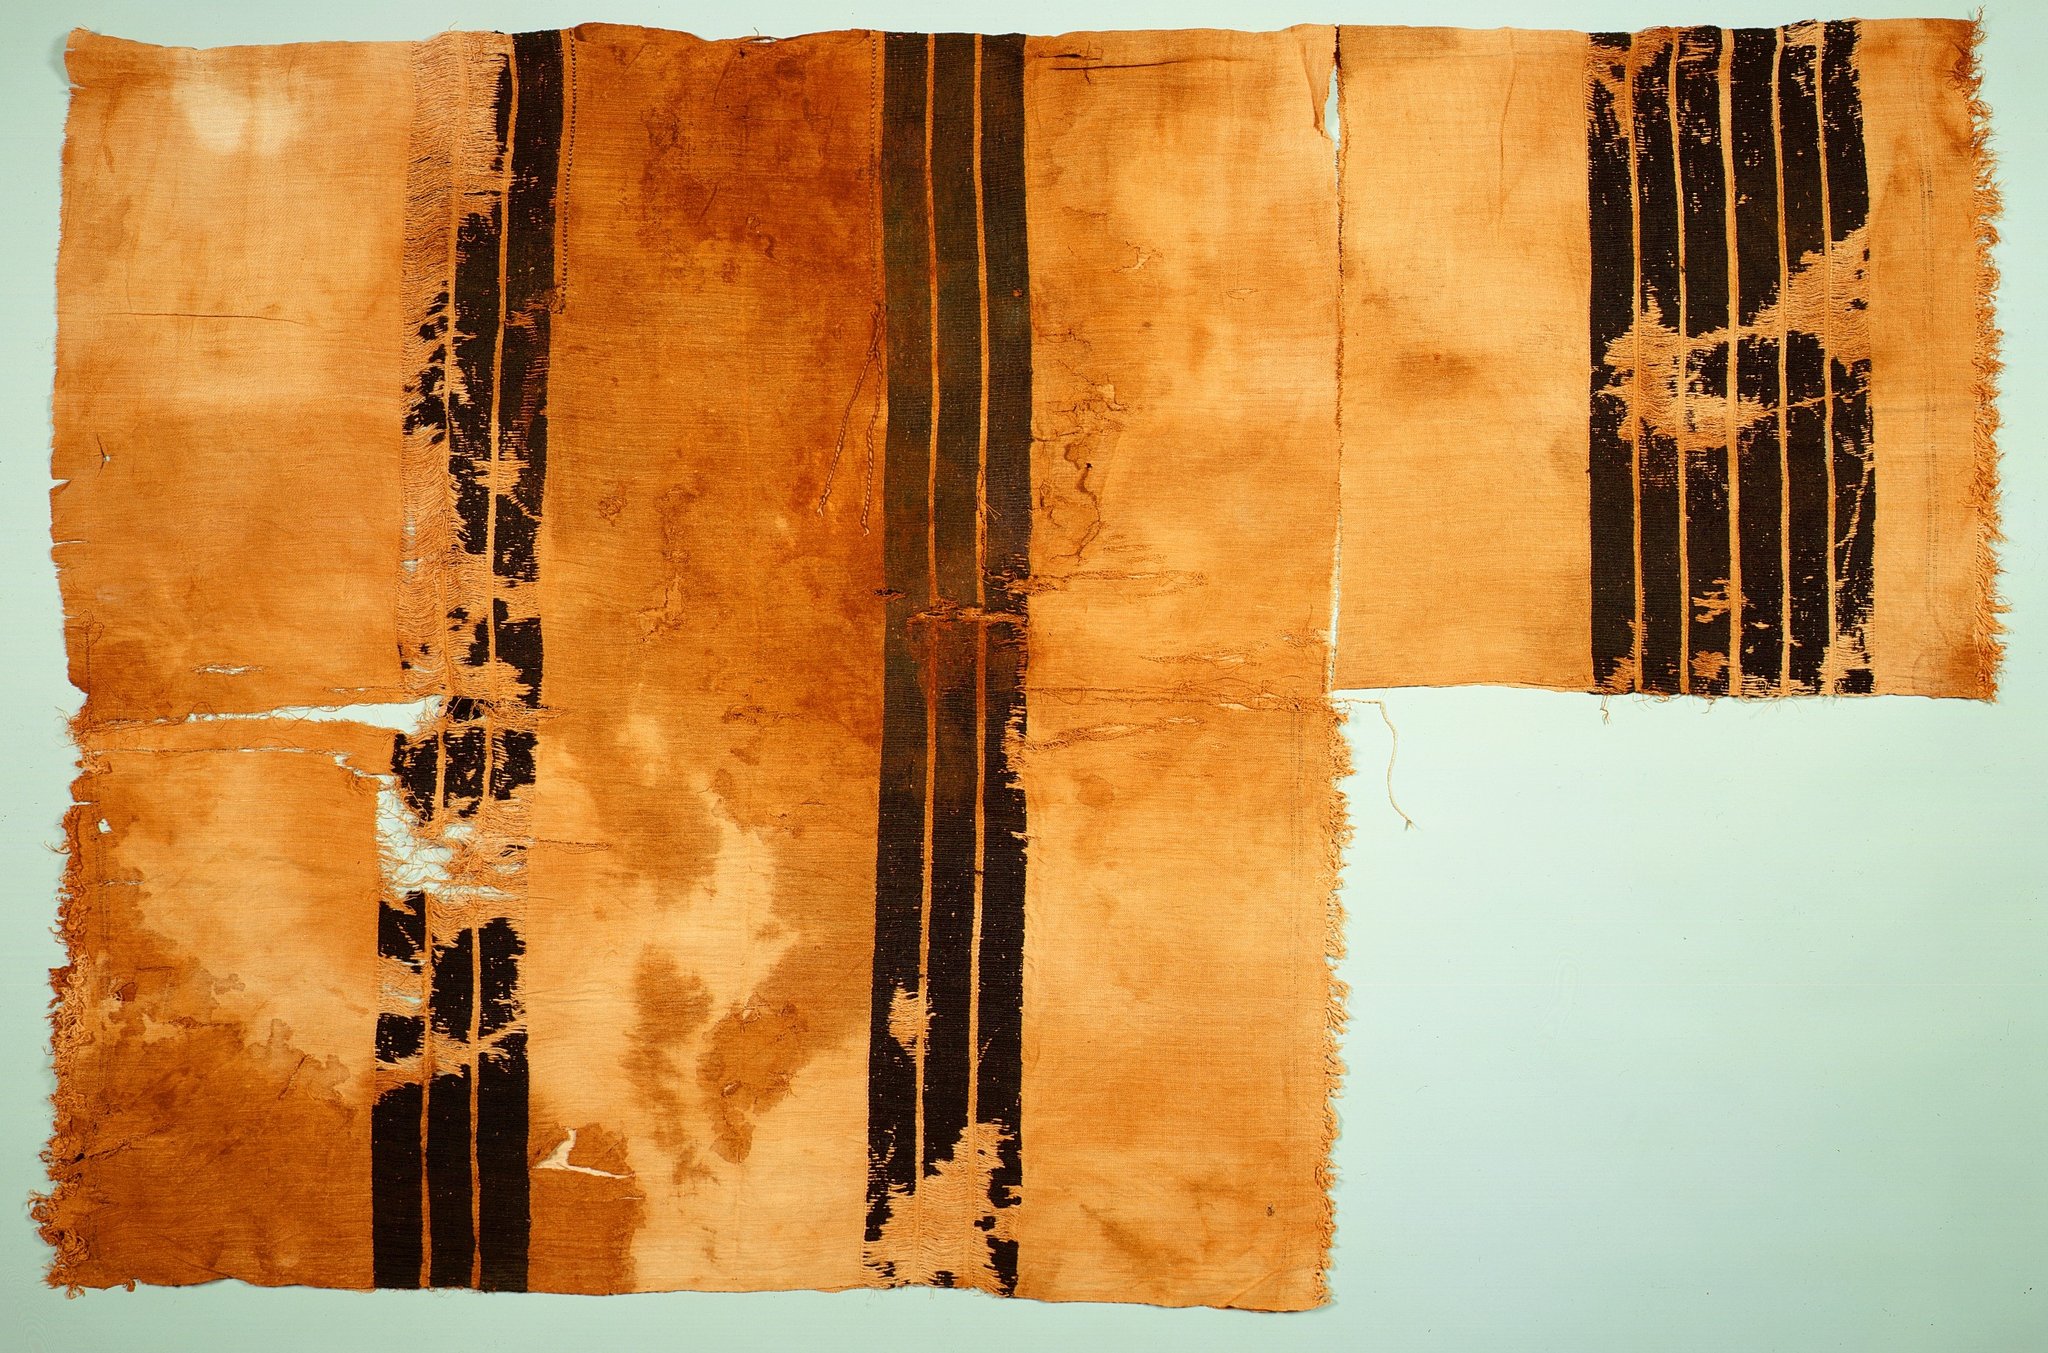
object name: dress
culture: coptic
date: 301-400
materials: linen, wool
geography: egypt